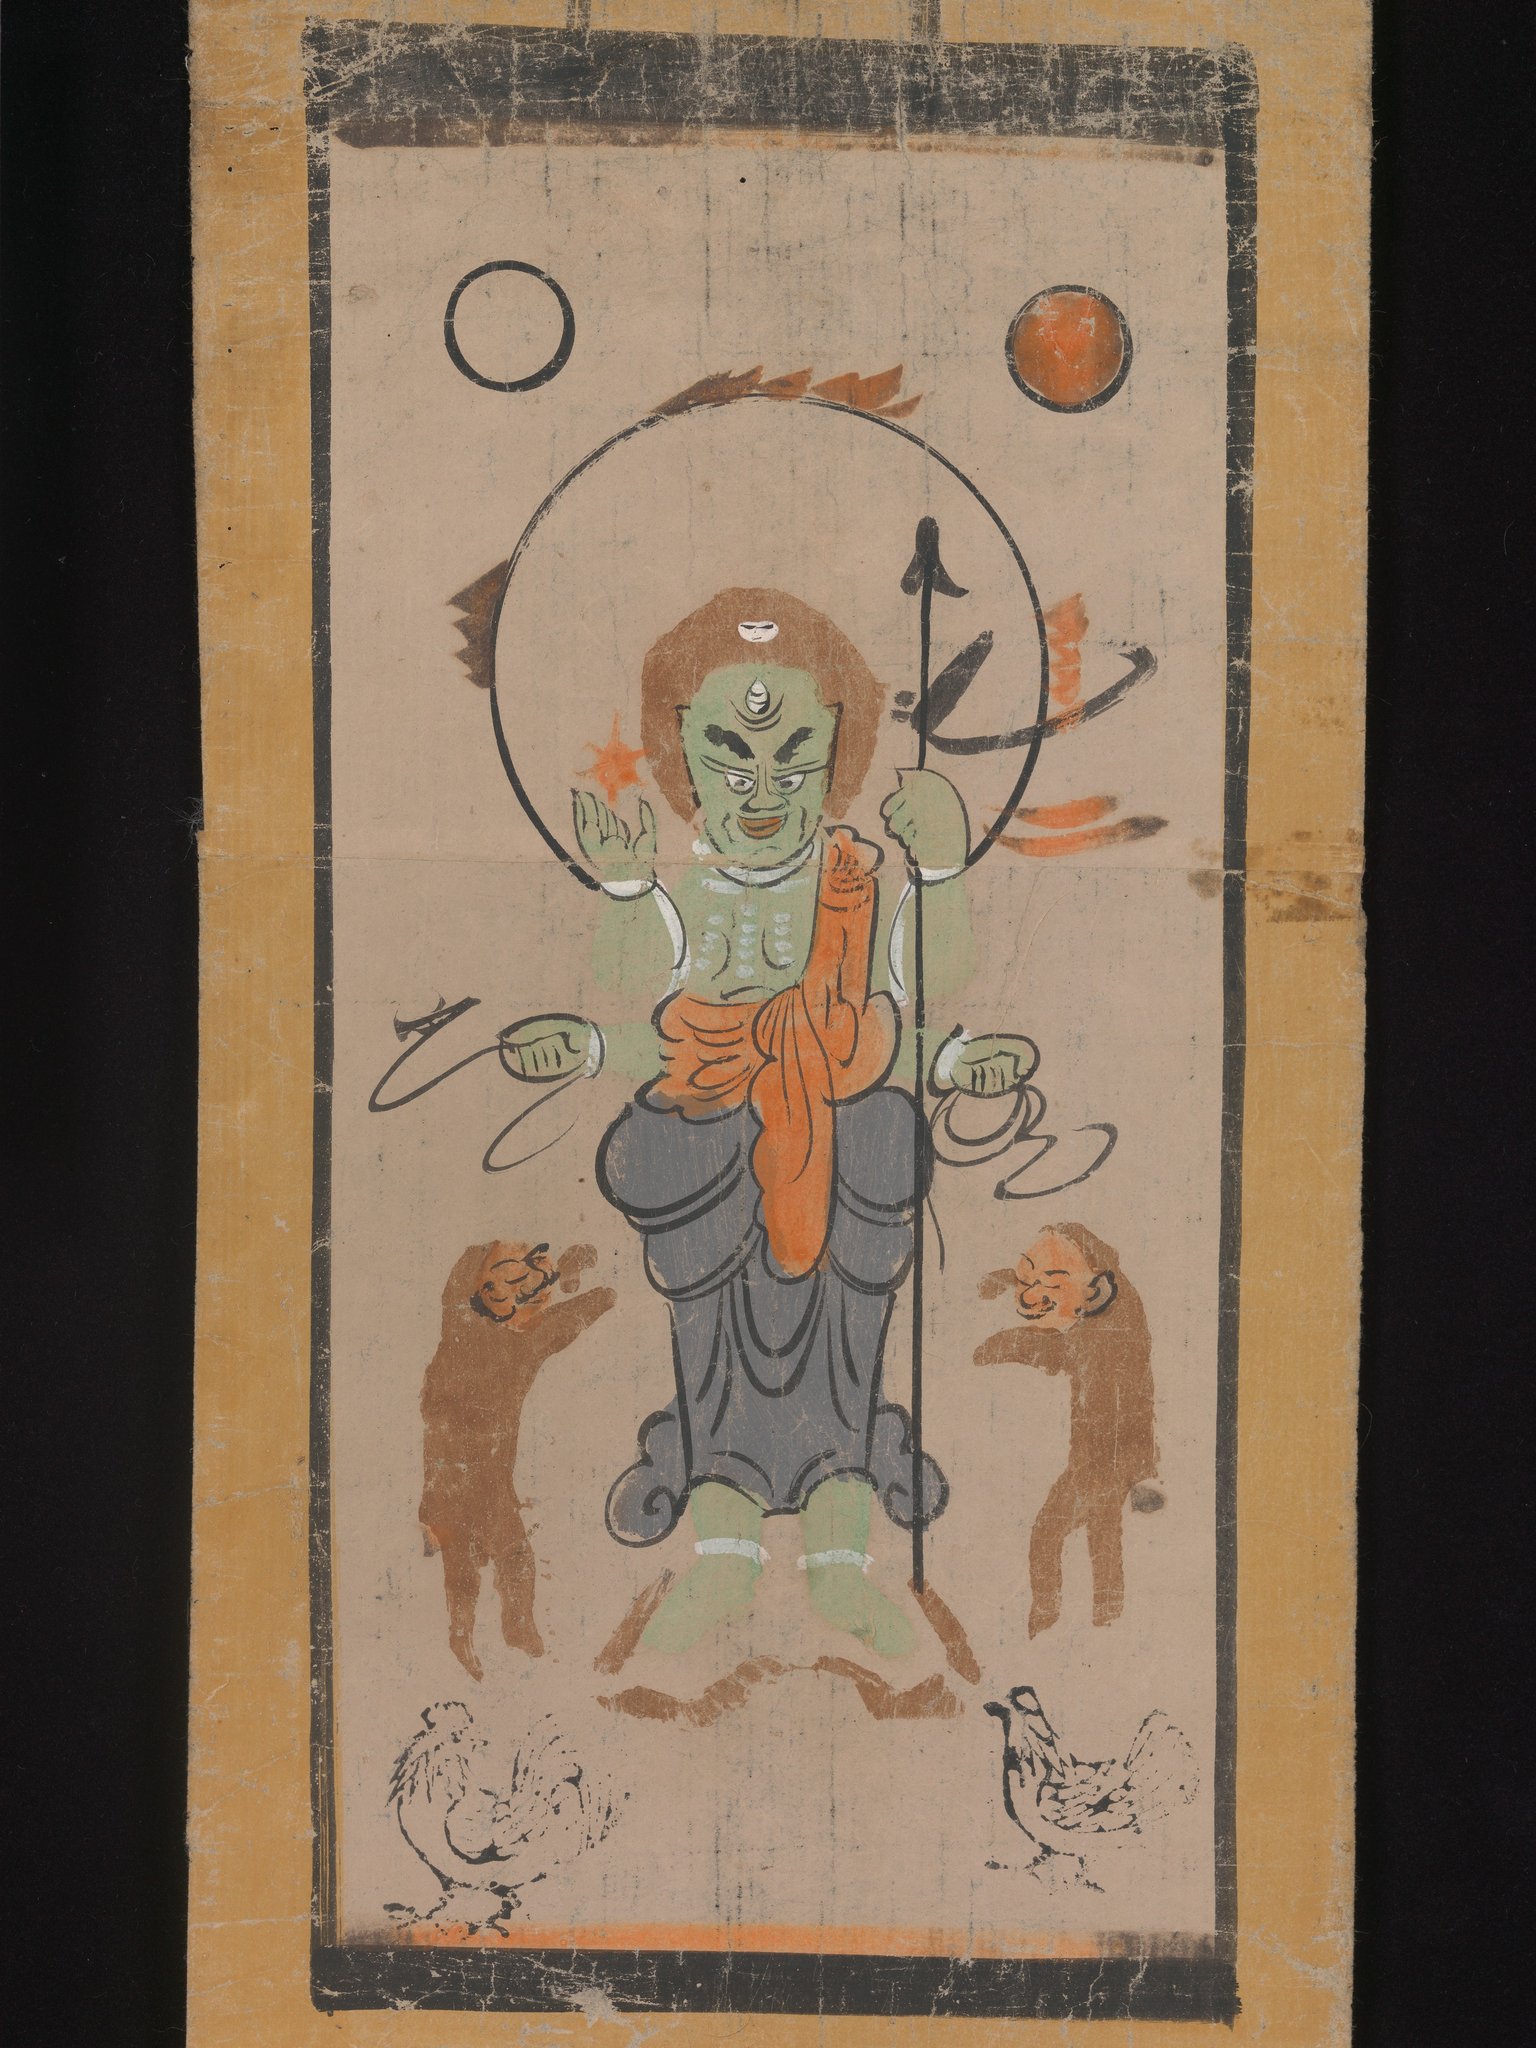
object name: hanging scroll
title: Ōtsu-e of Shōmen Kongōyasha (Vajrayaksha)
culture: japanese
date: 1601-1700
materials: ink, paper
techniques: hand coloring, woodblock print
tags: deities